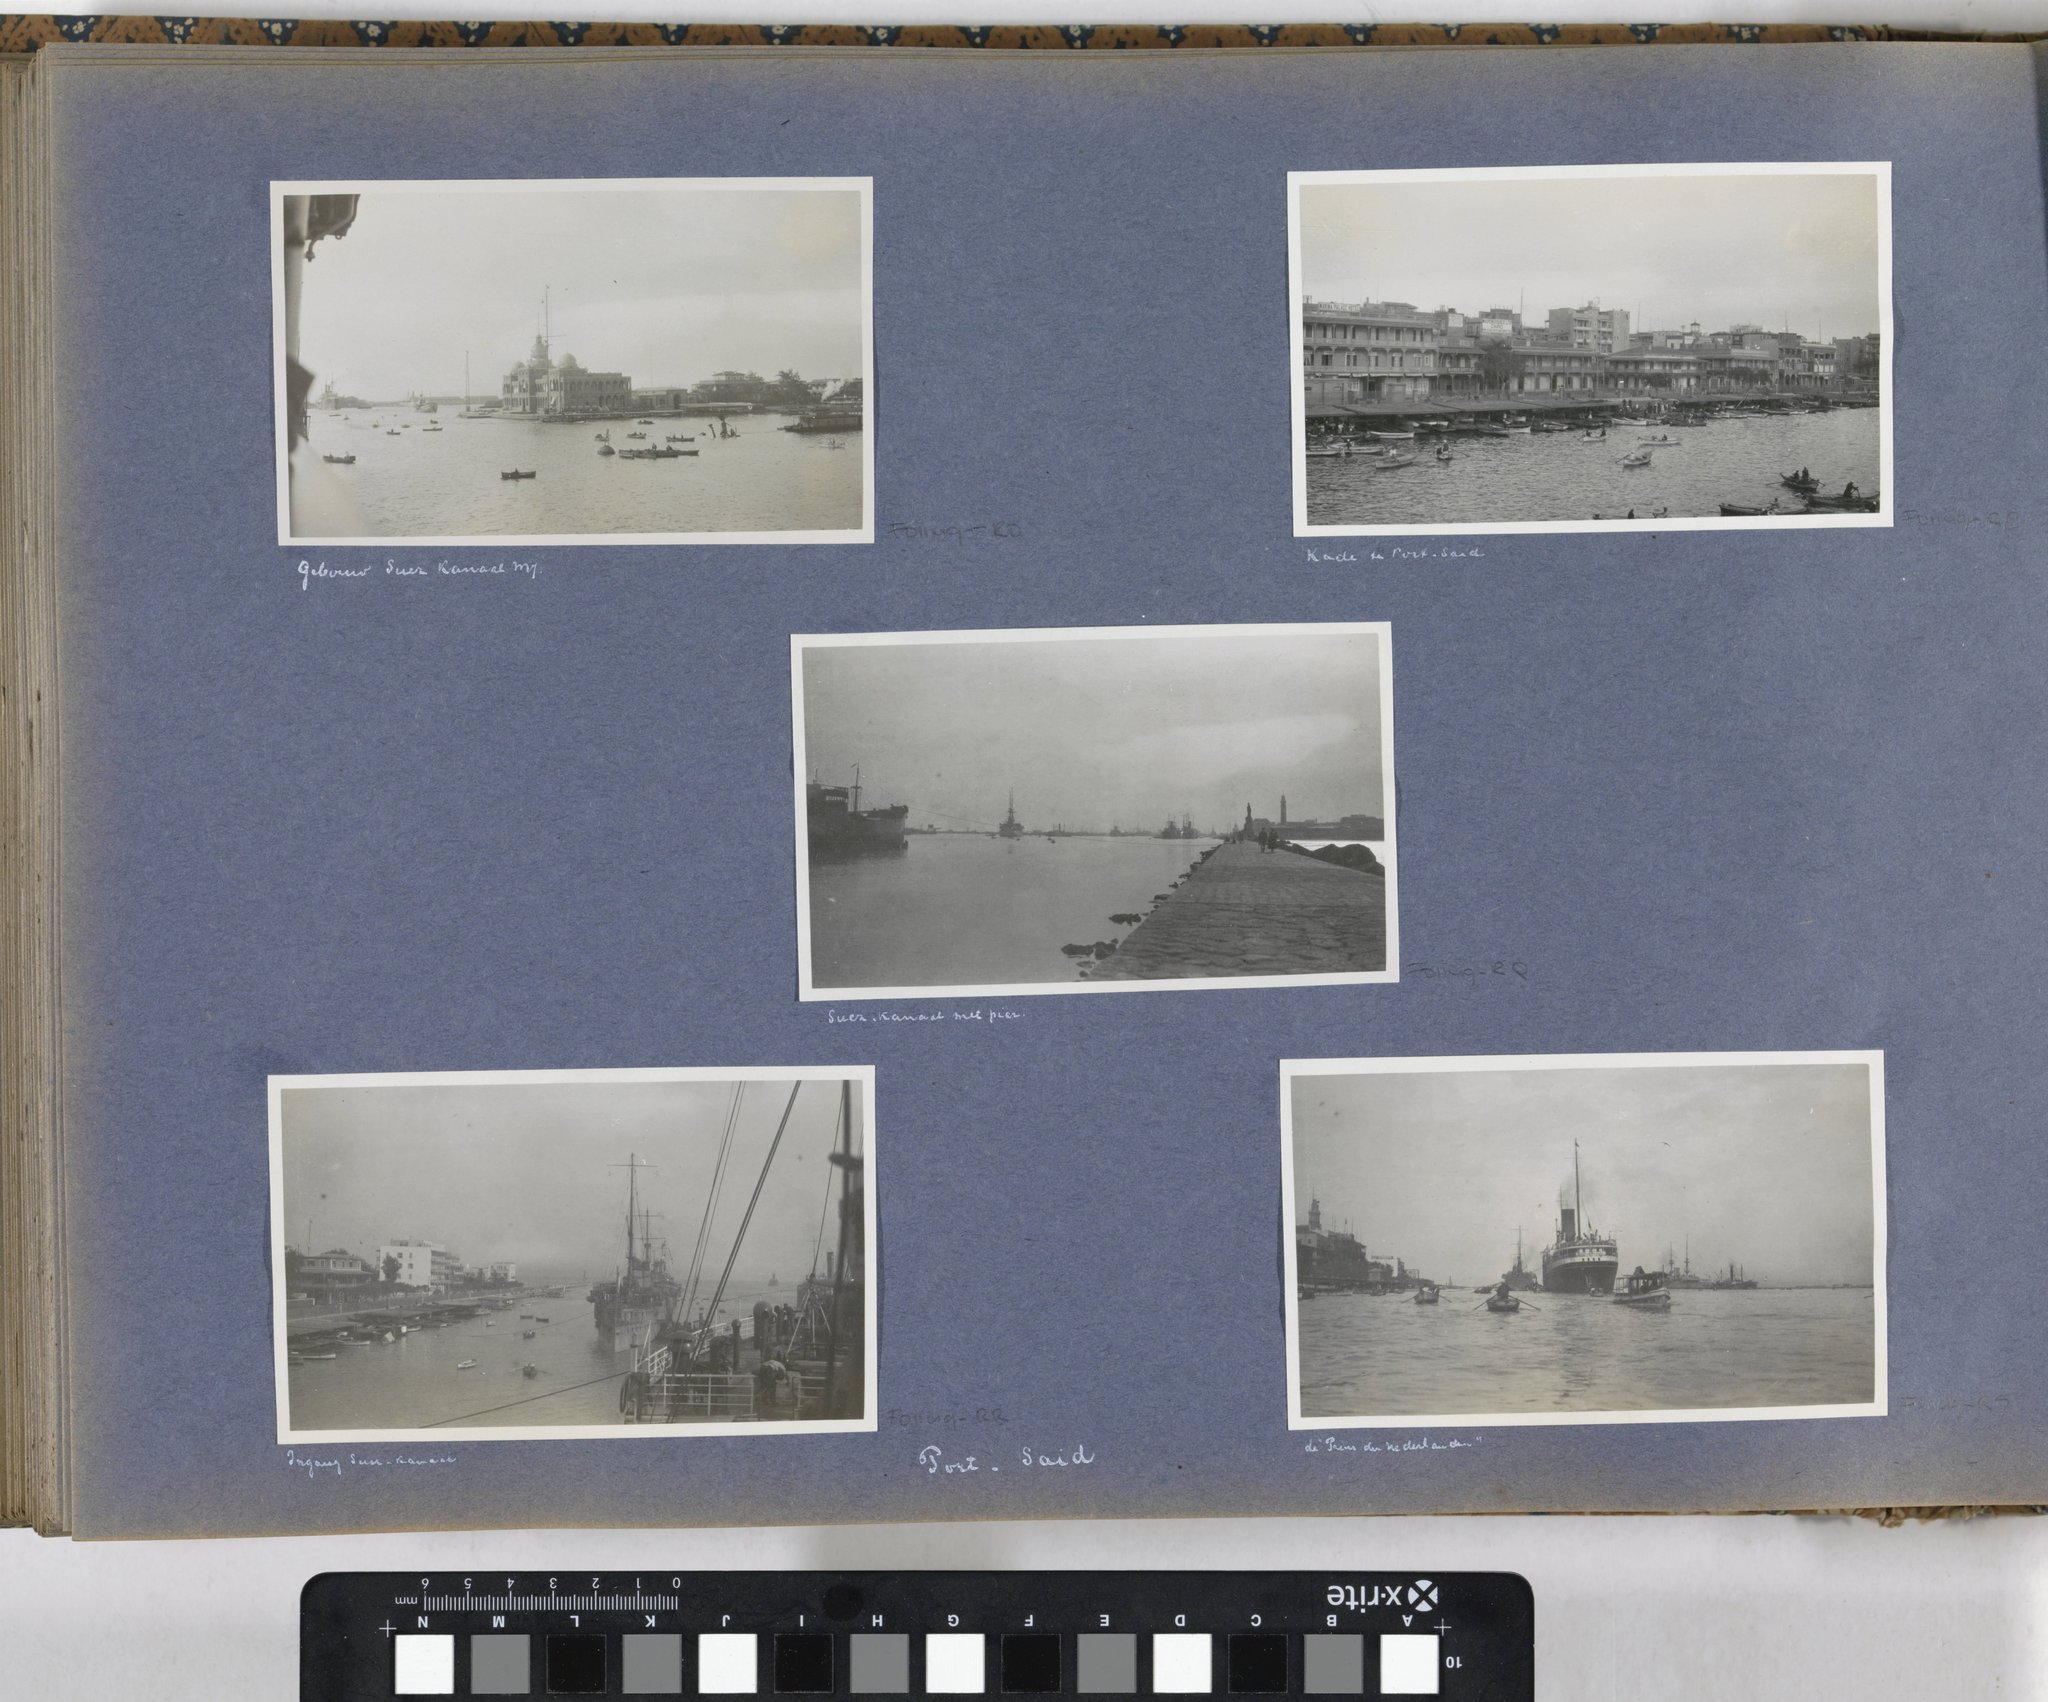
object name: photograph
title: Schepen in de ingang van het Suezkanaal in Port Said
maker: Anonymous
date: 1900-1920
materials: paper, photographic support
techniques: gelatin silver print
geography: port said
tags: harbour (+ view ~ vehicle, ship, etc.), canal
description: Onderdeel van reisalbum met foto's van bedrijvigheid en bezienswaardigheden op Sumatra en Java en van de reis naar en van Nederlands-Indië.